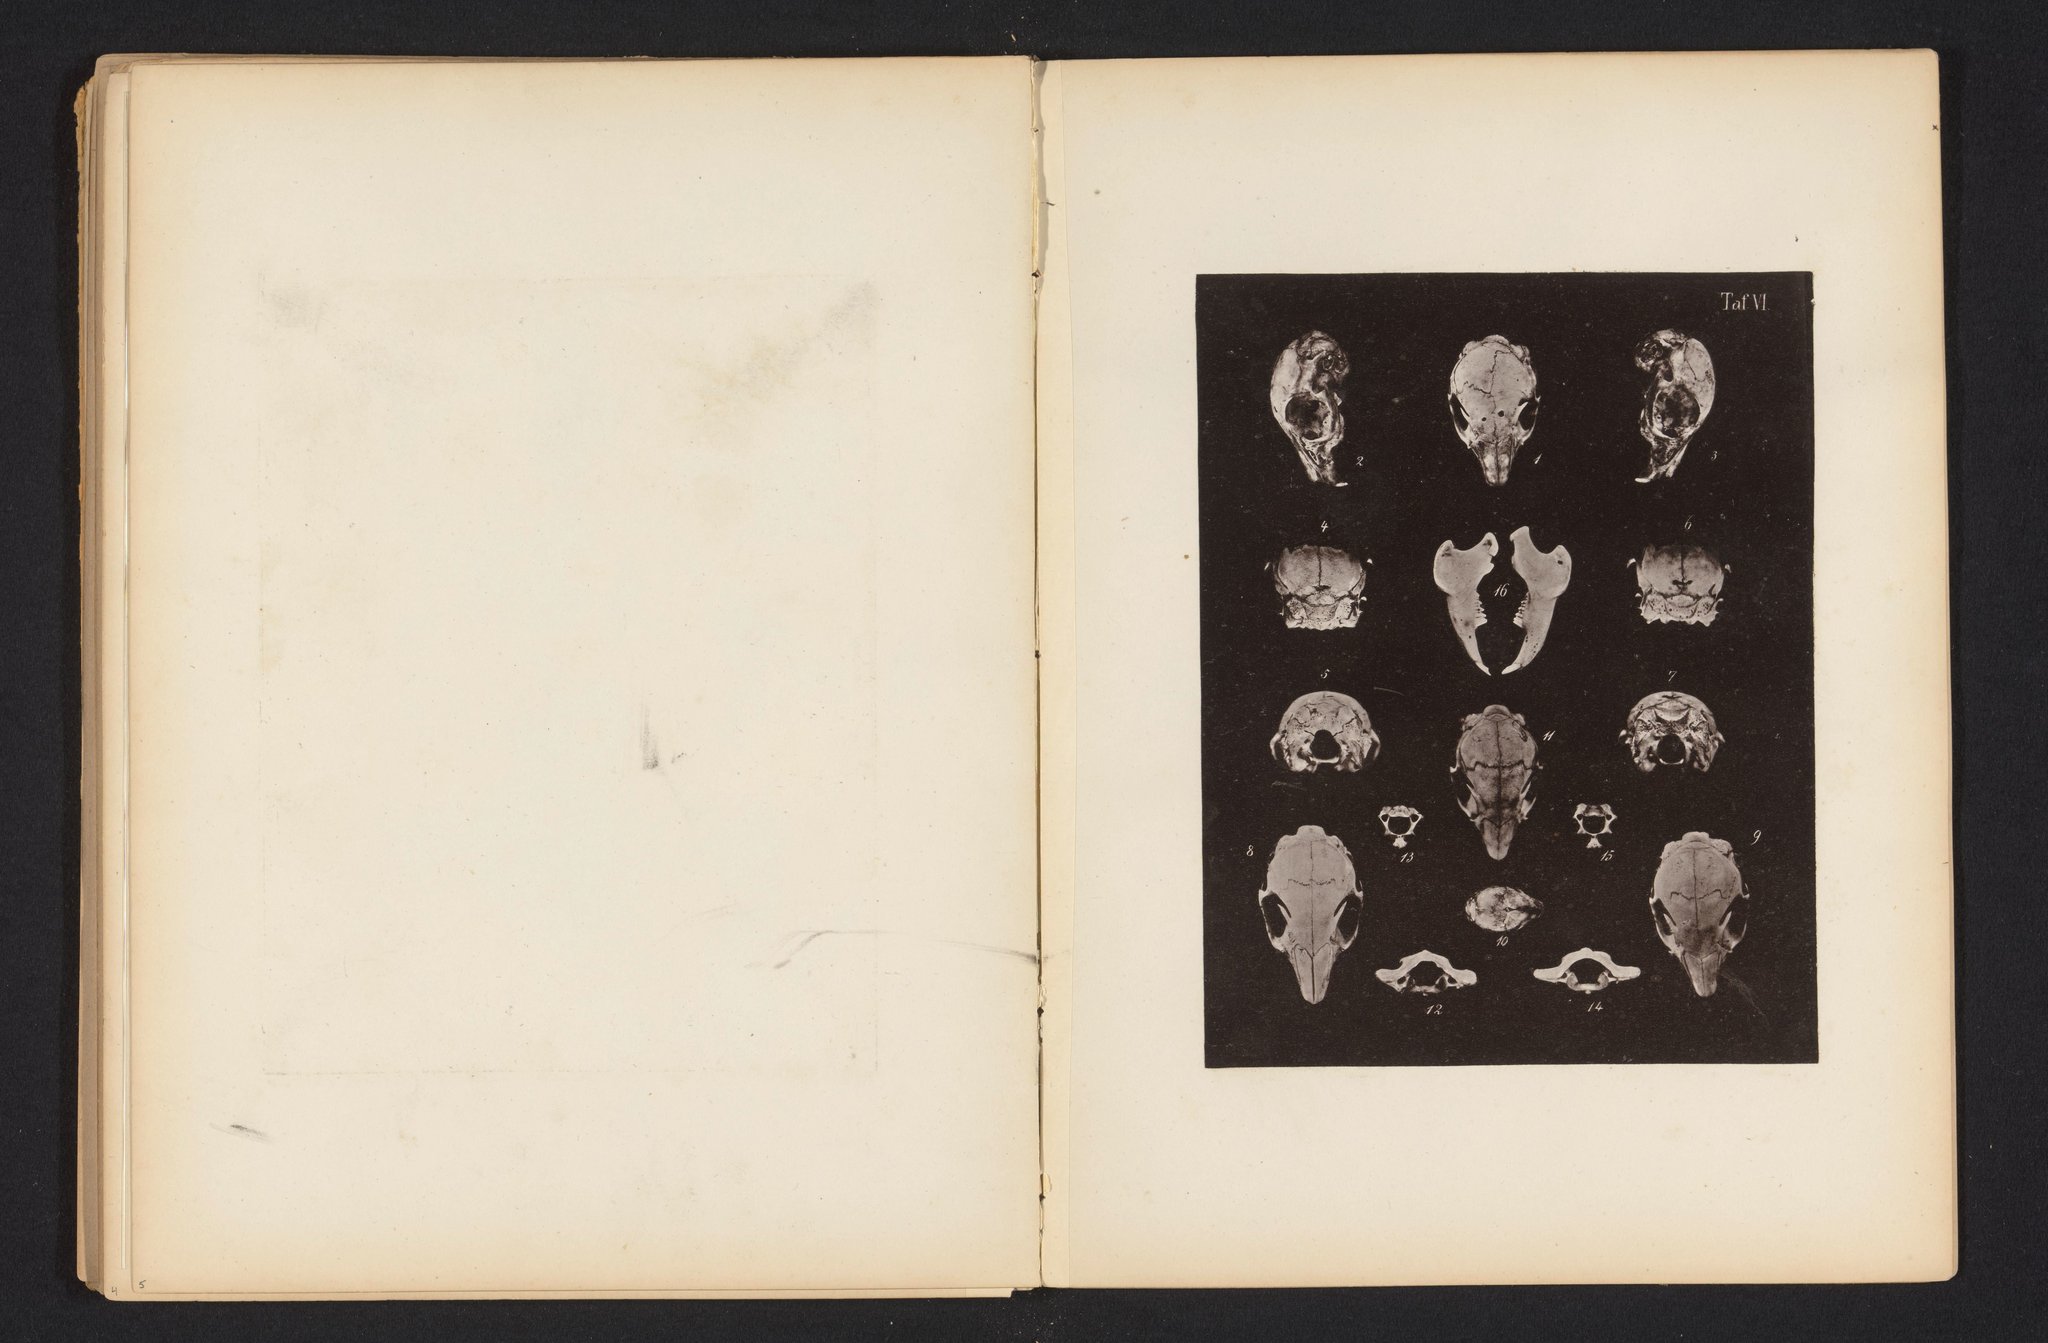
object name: page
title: Vijftien aangezichten van een konijnenschedel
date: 1864-1874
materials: paper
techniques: photograph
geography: munich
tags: (human) skull, rodents: rabbit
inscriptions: number: ‘Taf. VI. 1 2 3 4 5 6 7 8 9 10 11 12 13 14 15’